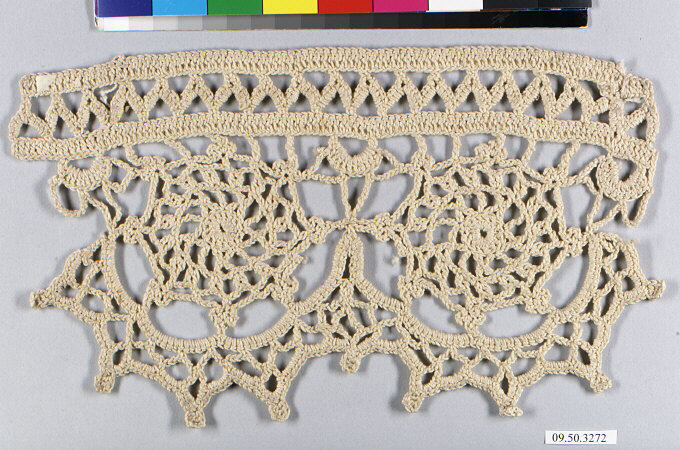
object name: sample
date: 1801-1900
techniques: crochet